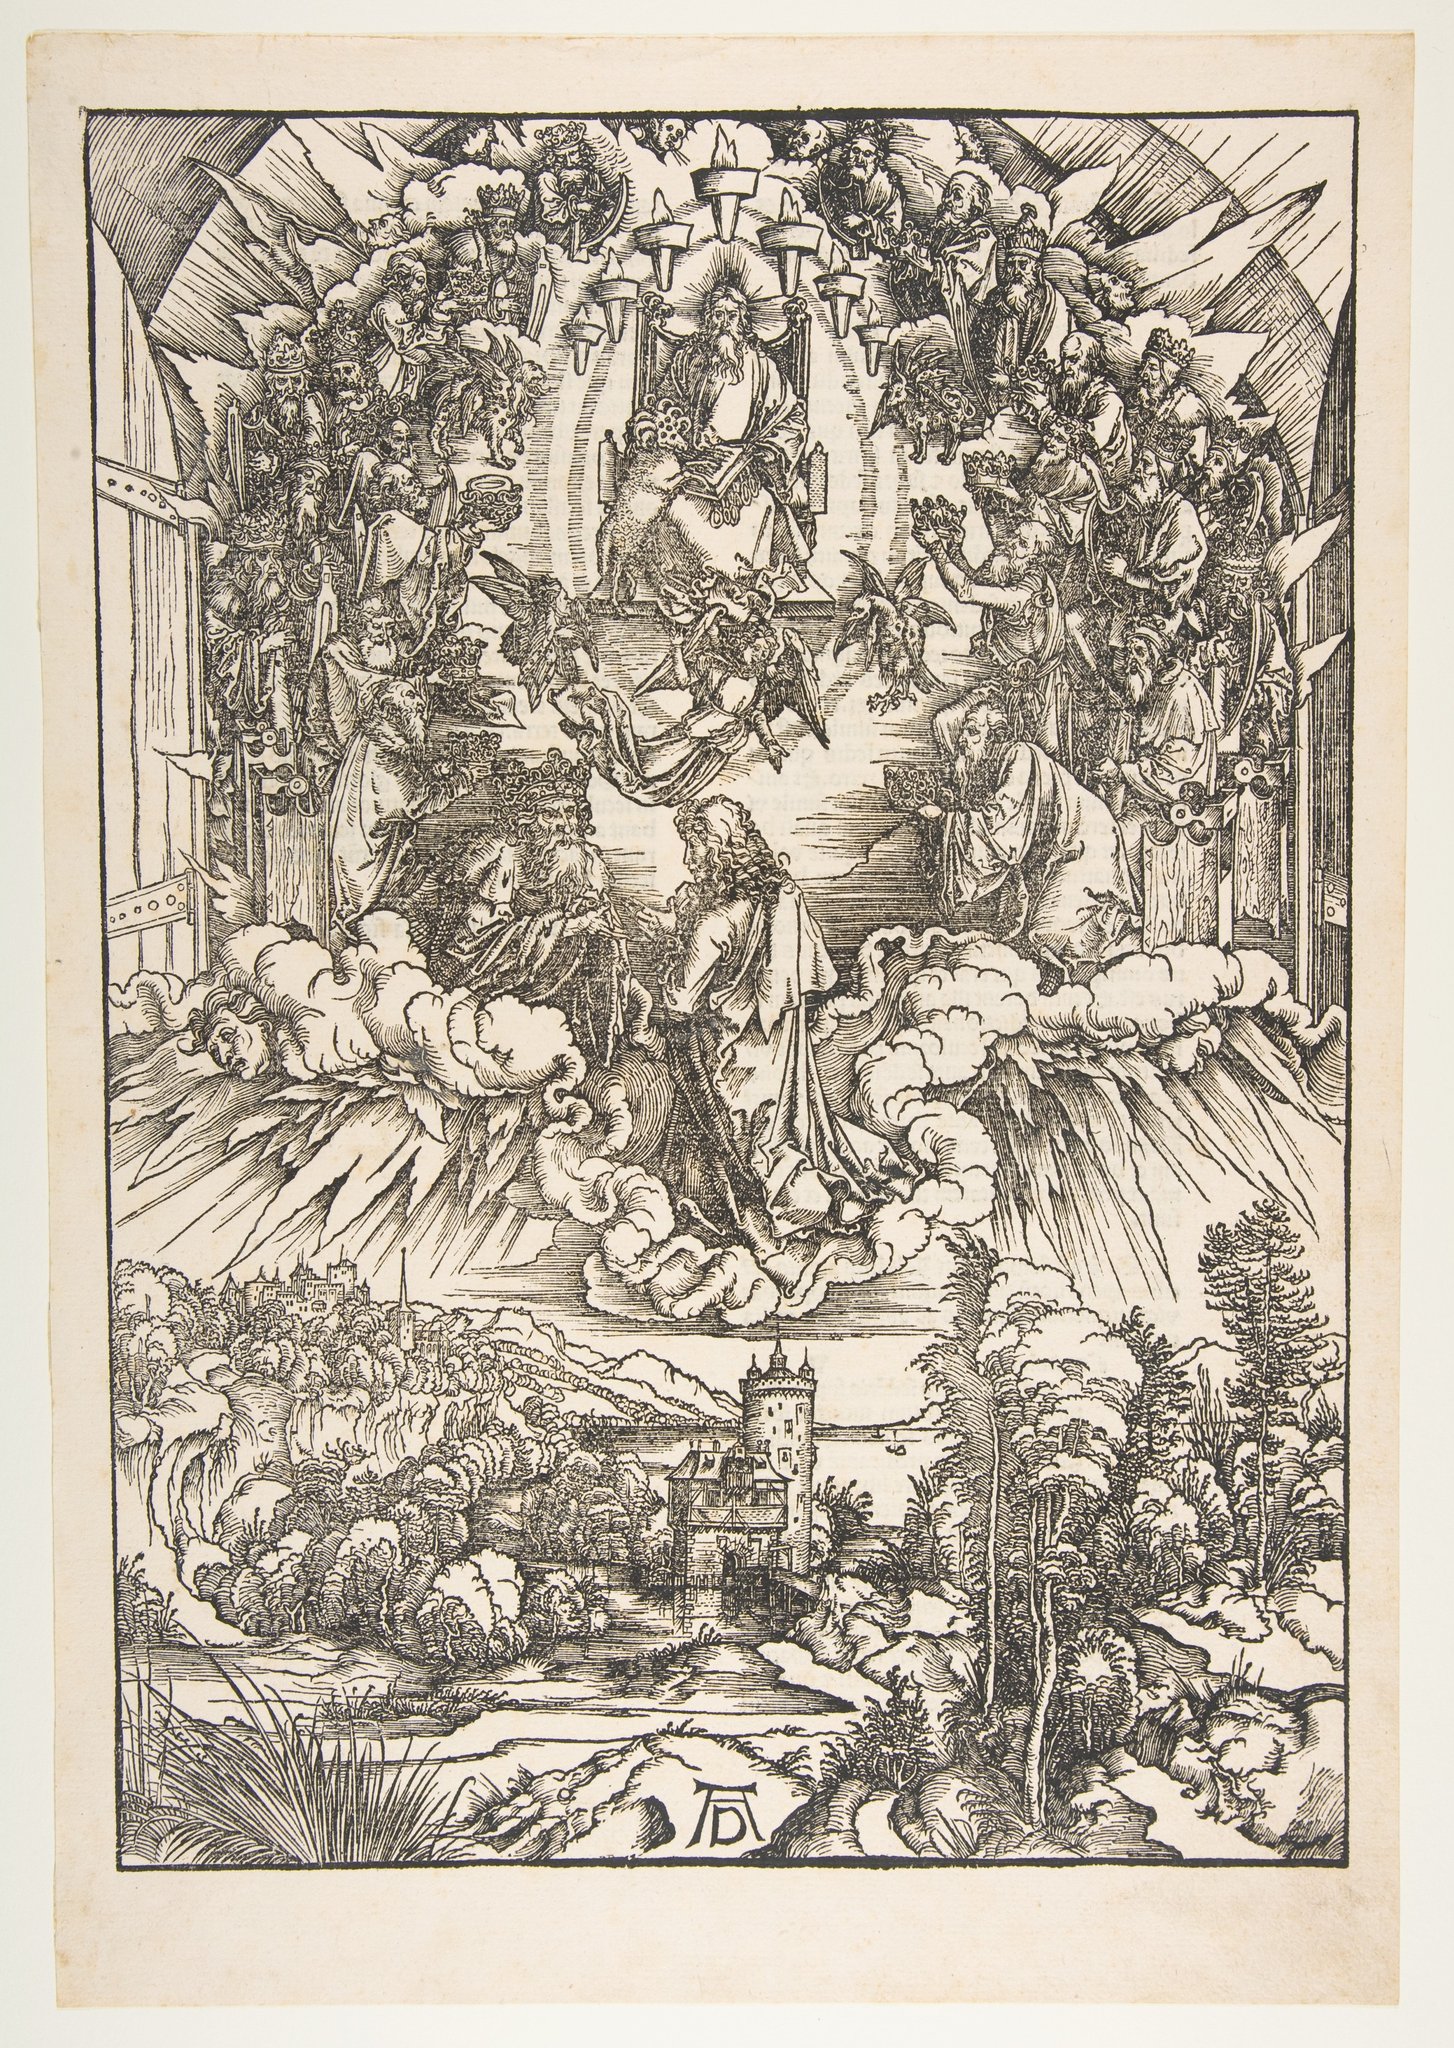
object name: print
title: Saint John Before God and the Elders, from "The Apocalypse"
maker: albrecht dürer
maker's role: artist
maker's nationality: german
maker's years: 1471-1528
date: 1498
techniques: woodcut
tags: angels,apocalypse,saints,god the father